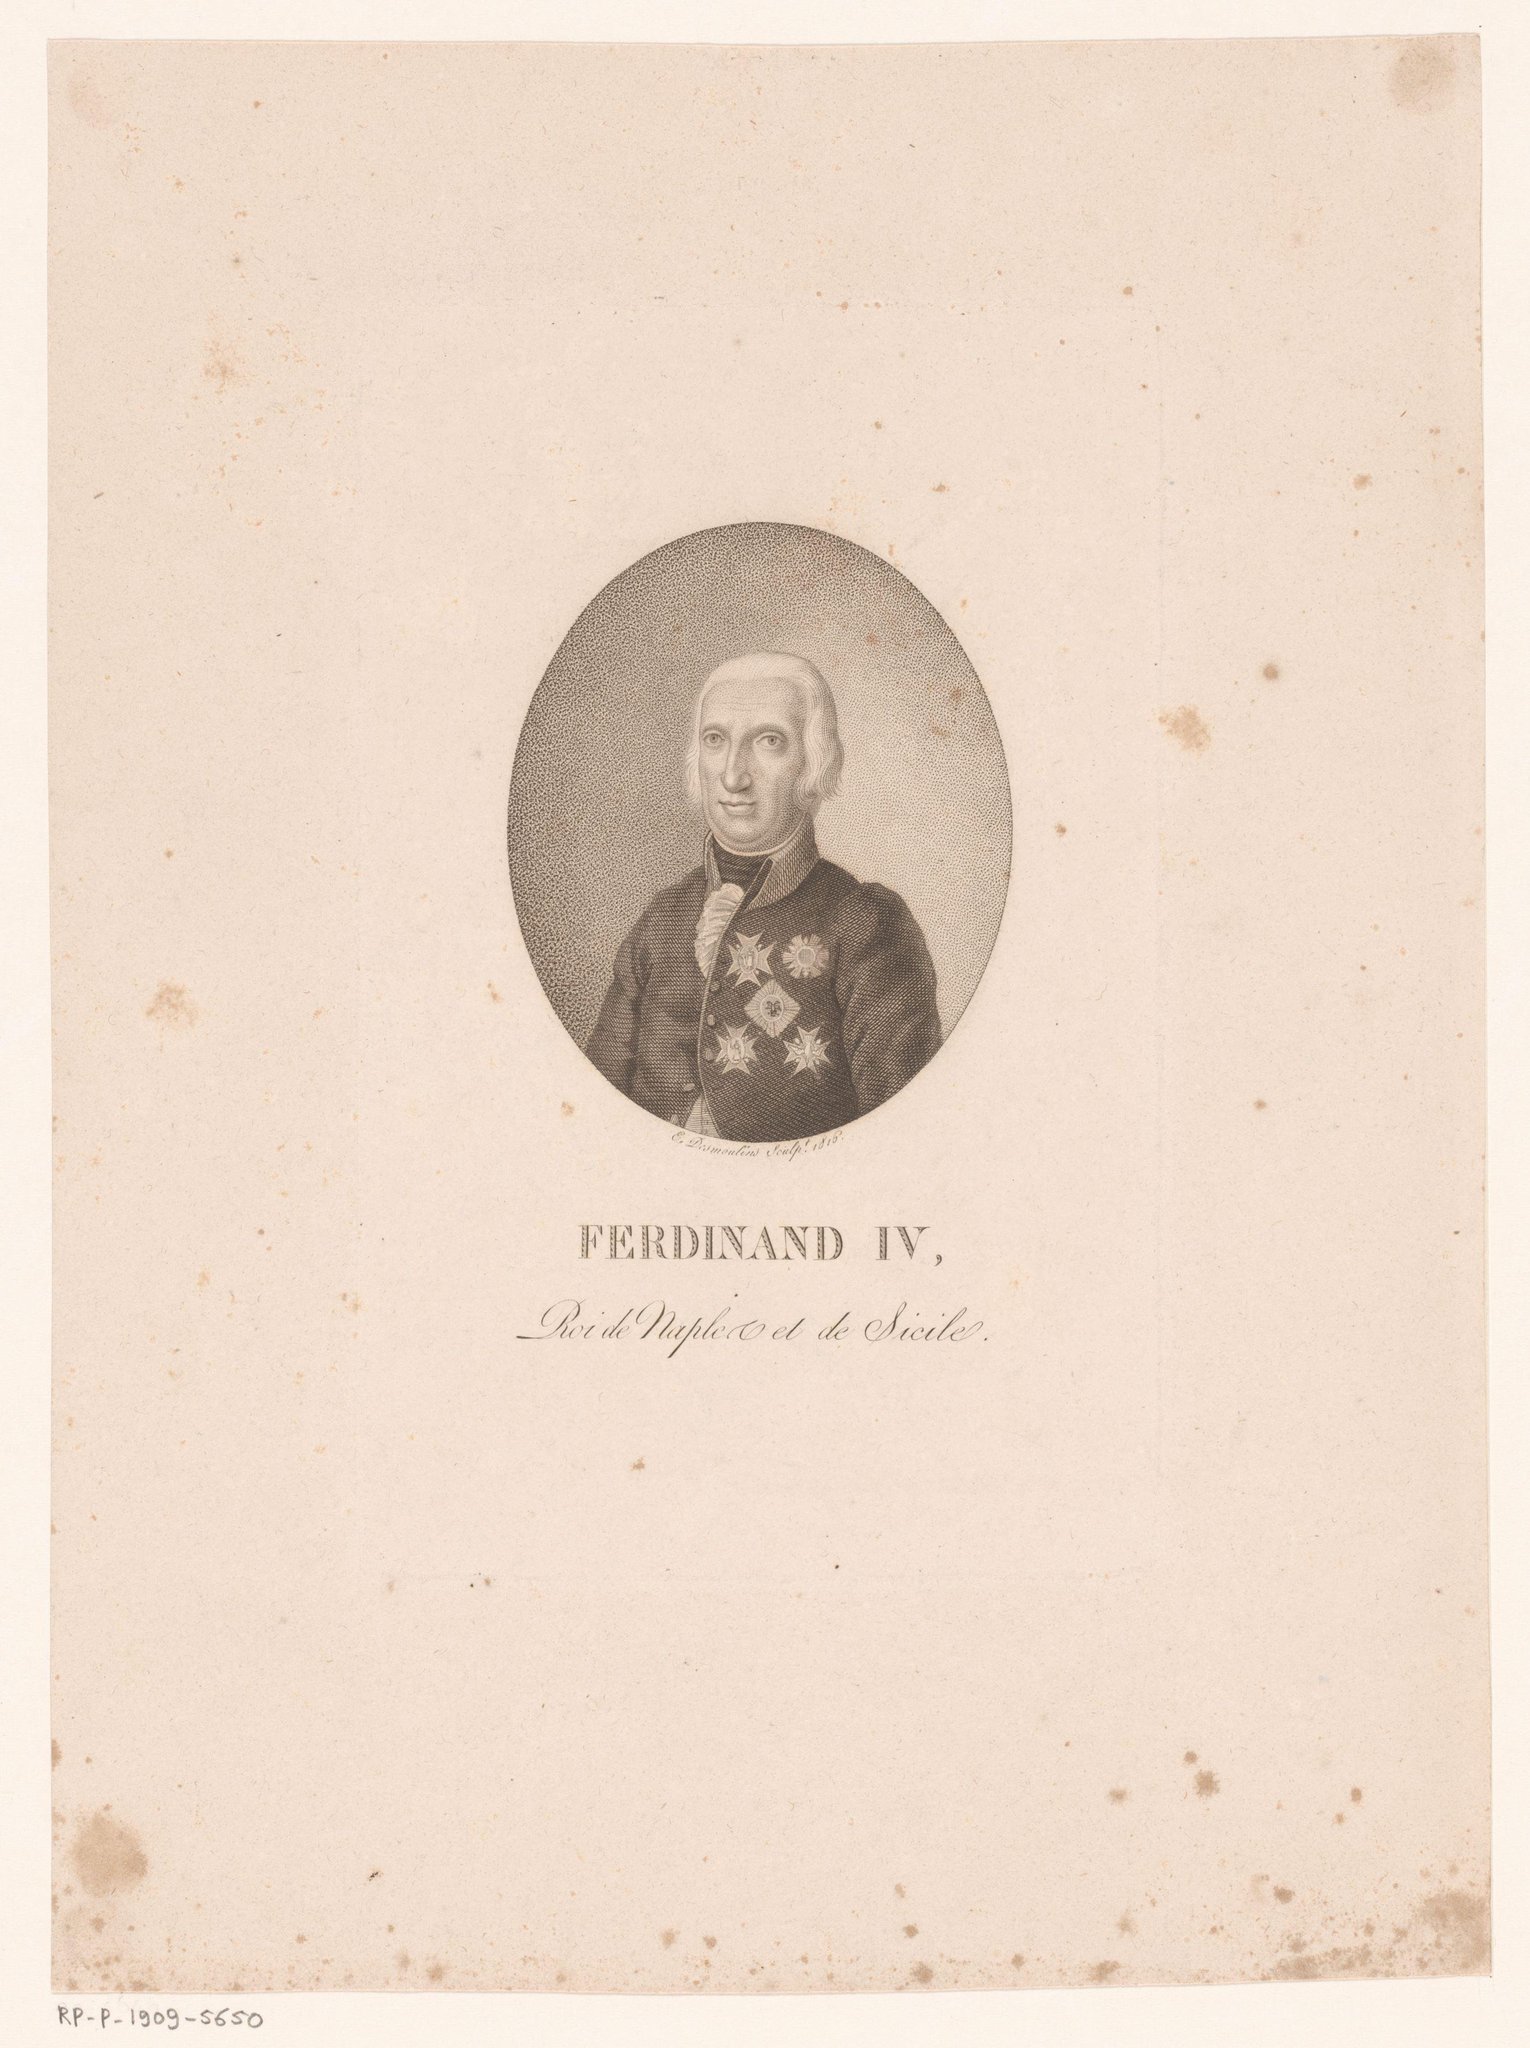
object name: print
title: Portret van Ferdinand I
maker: jean emanuel desmoulins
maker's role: print maker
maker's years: 1793-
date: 1816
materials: paper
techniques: etching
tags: naples, ferdinand i (koning der beide siciliën), historical persons, decorations, honours (as symbols of the state, etc.), king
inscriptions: collector's mark: Lugt 2228